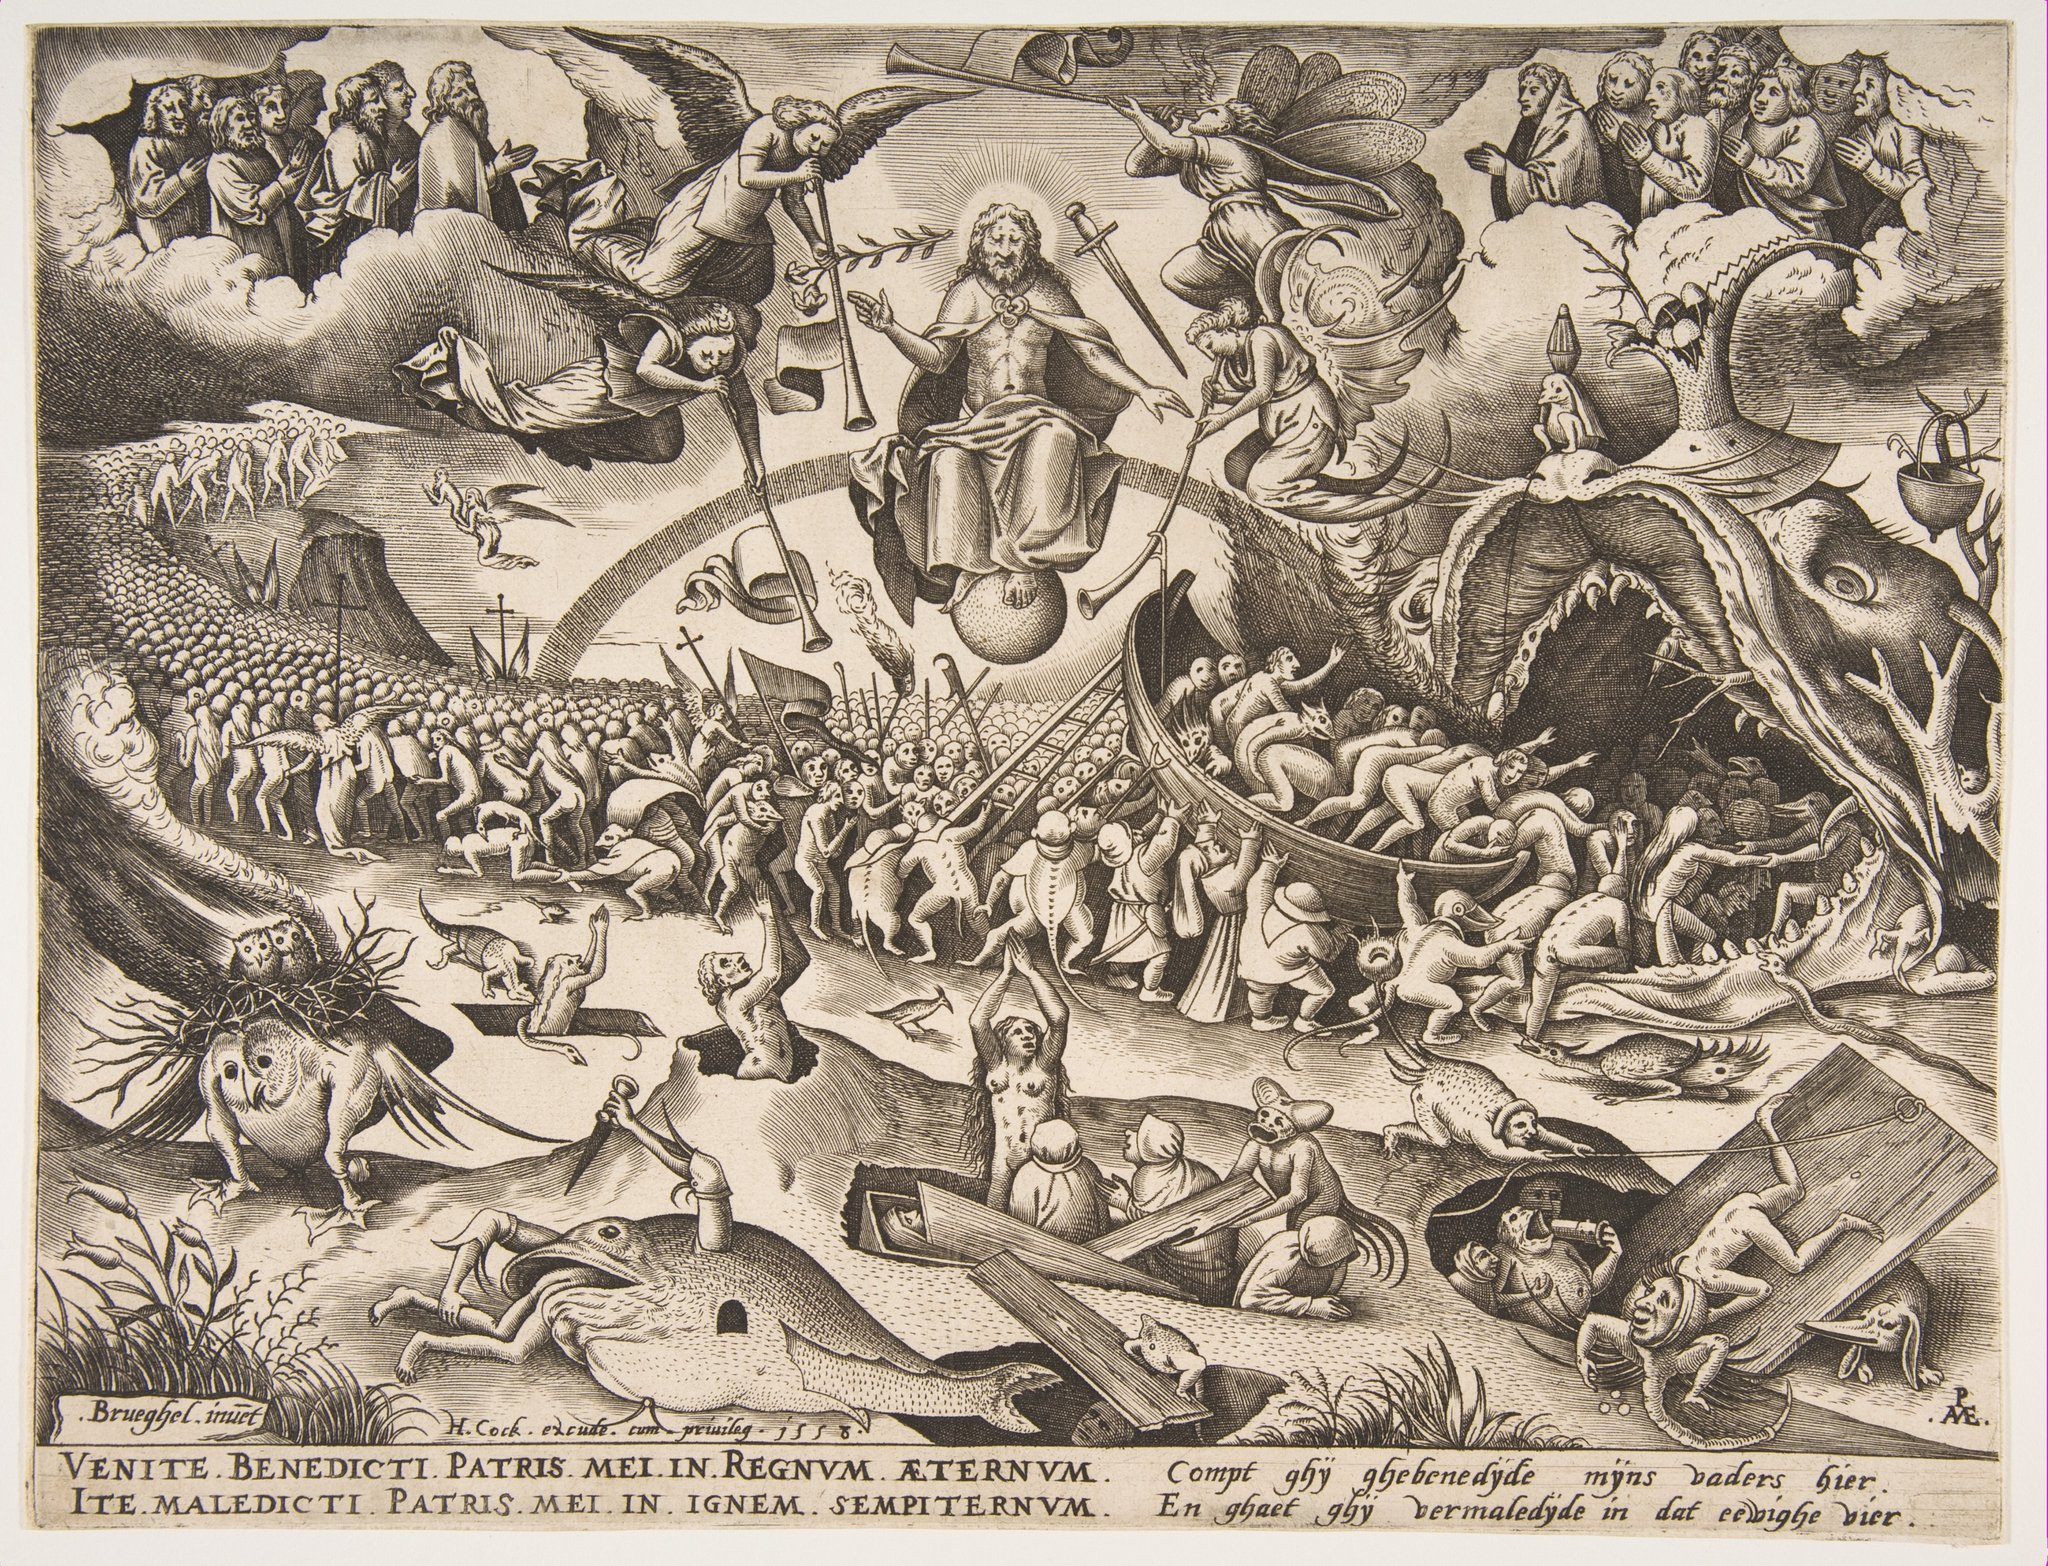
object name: print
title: The Last Judgment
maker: pieter van der heyden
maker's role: artist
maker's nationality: netherlandish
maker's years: 1525-1569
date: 1558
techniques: engraving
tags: last judgement